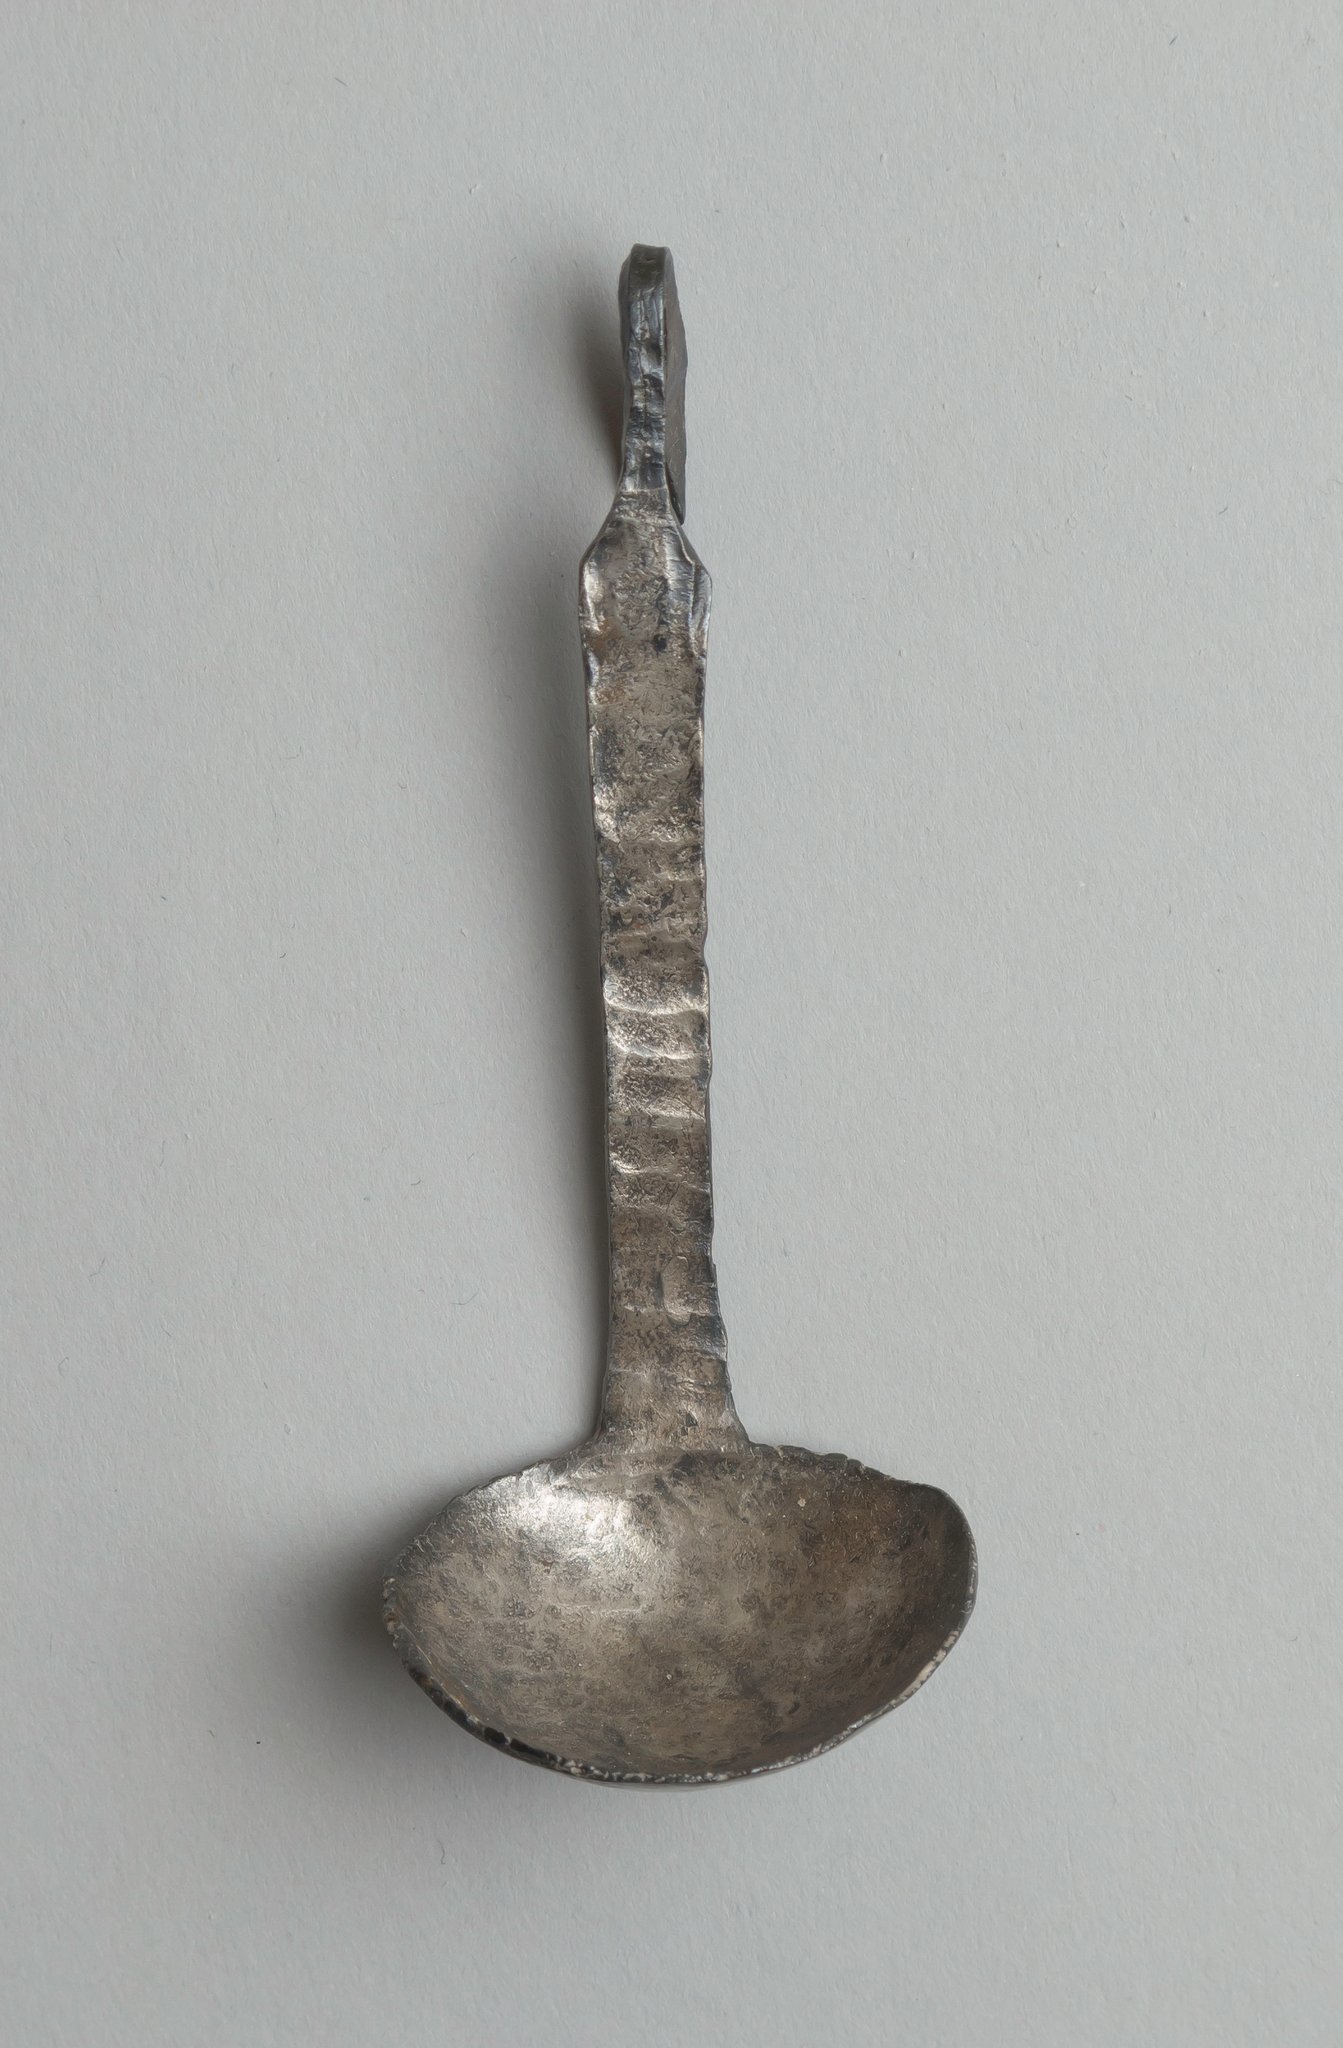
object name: ladle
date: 7000 BCE-330 CE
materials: silver